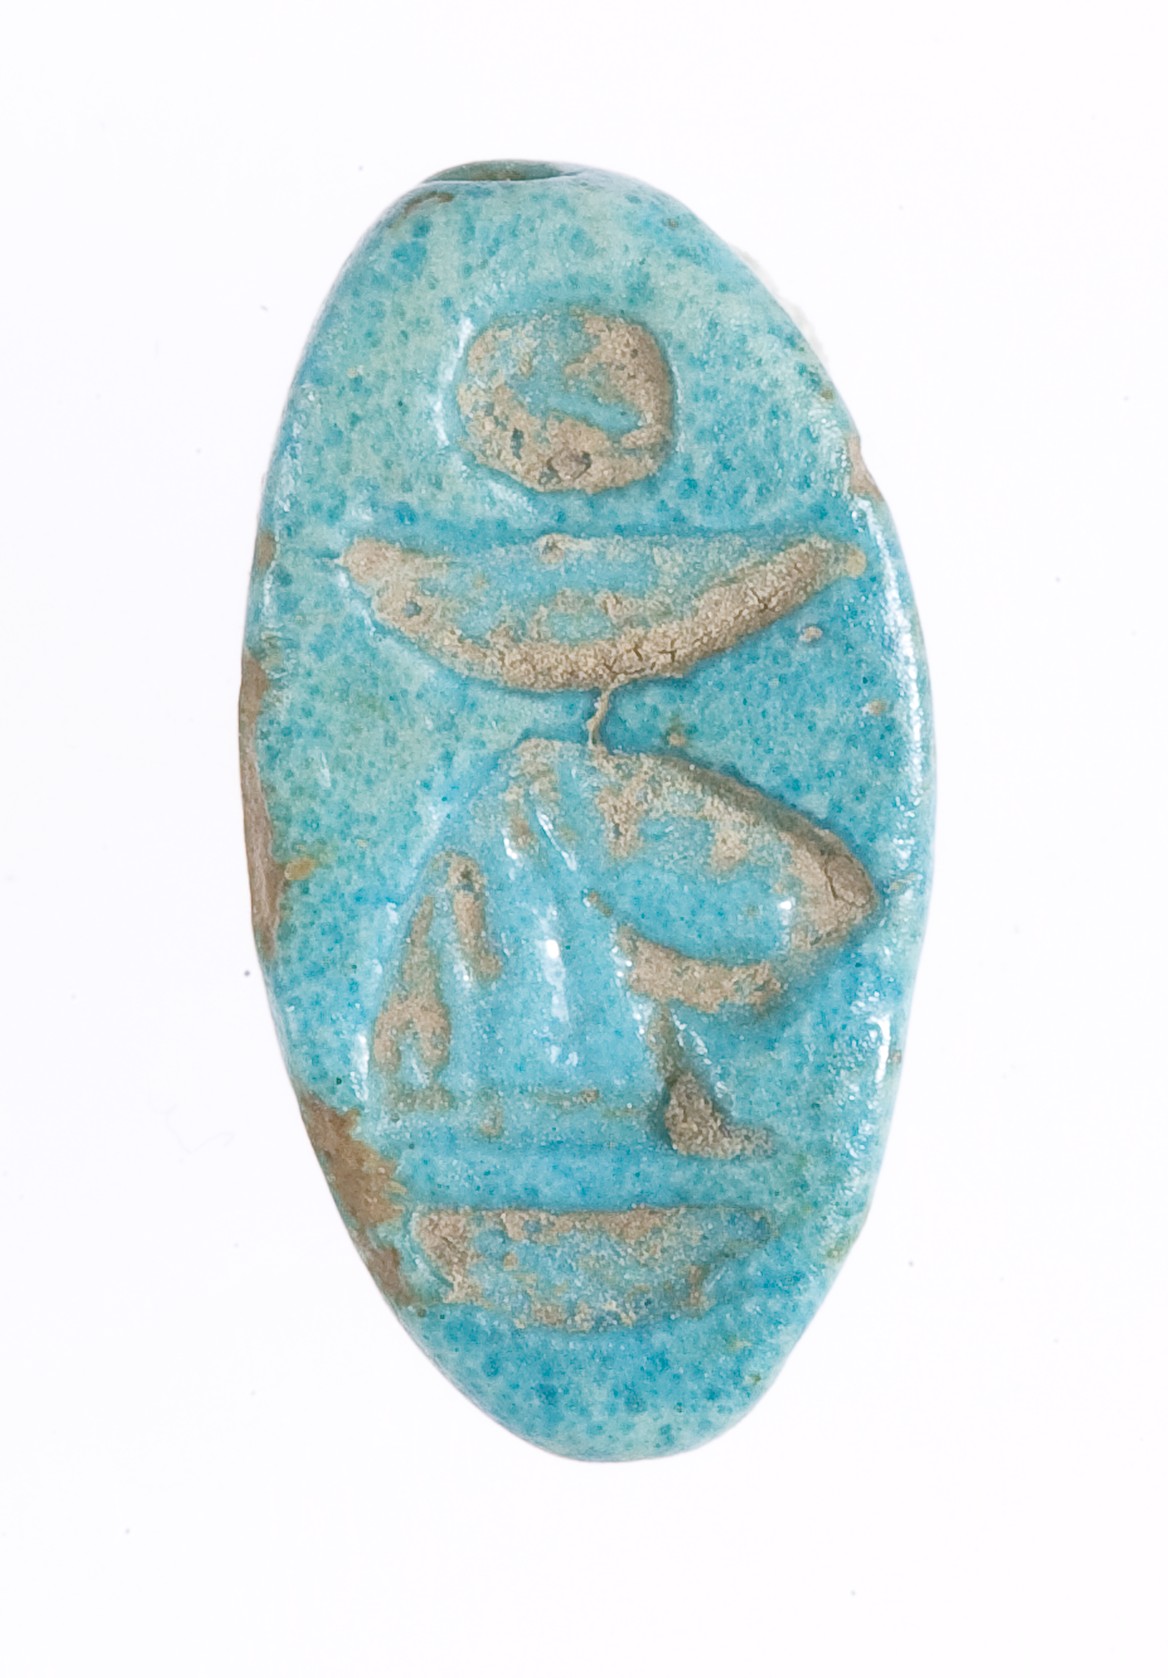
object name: scarab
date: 1550-1525 BCE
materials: pottery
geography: egypt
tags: hieroglyphs,scarabs